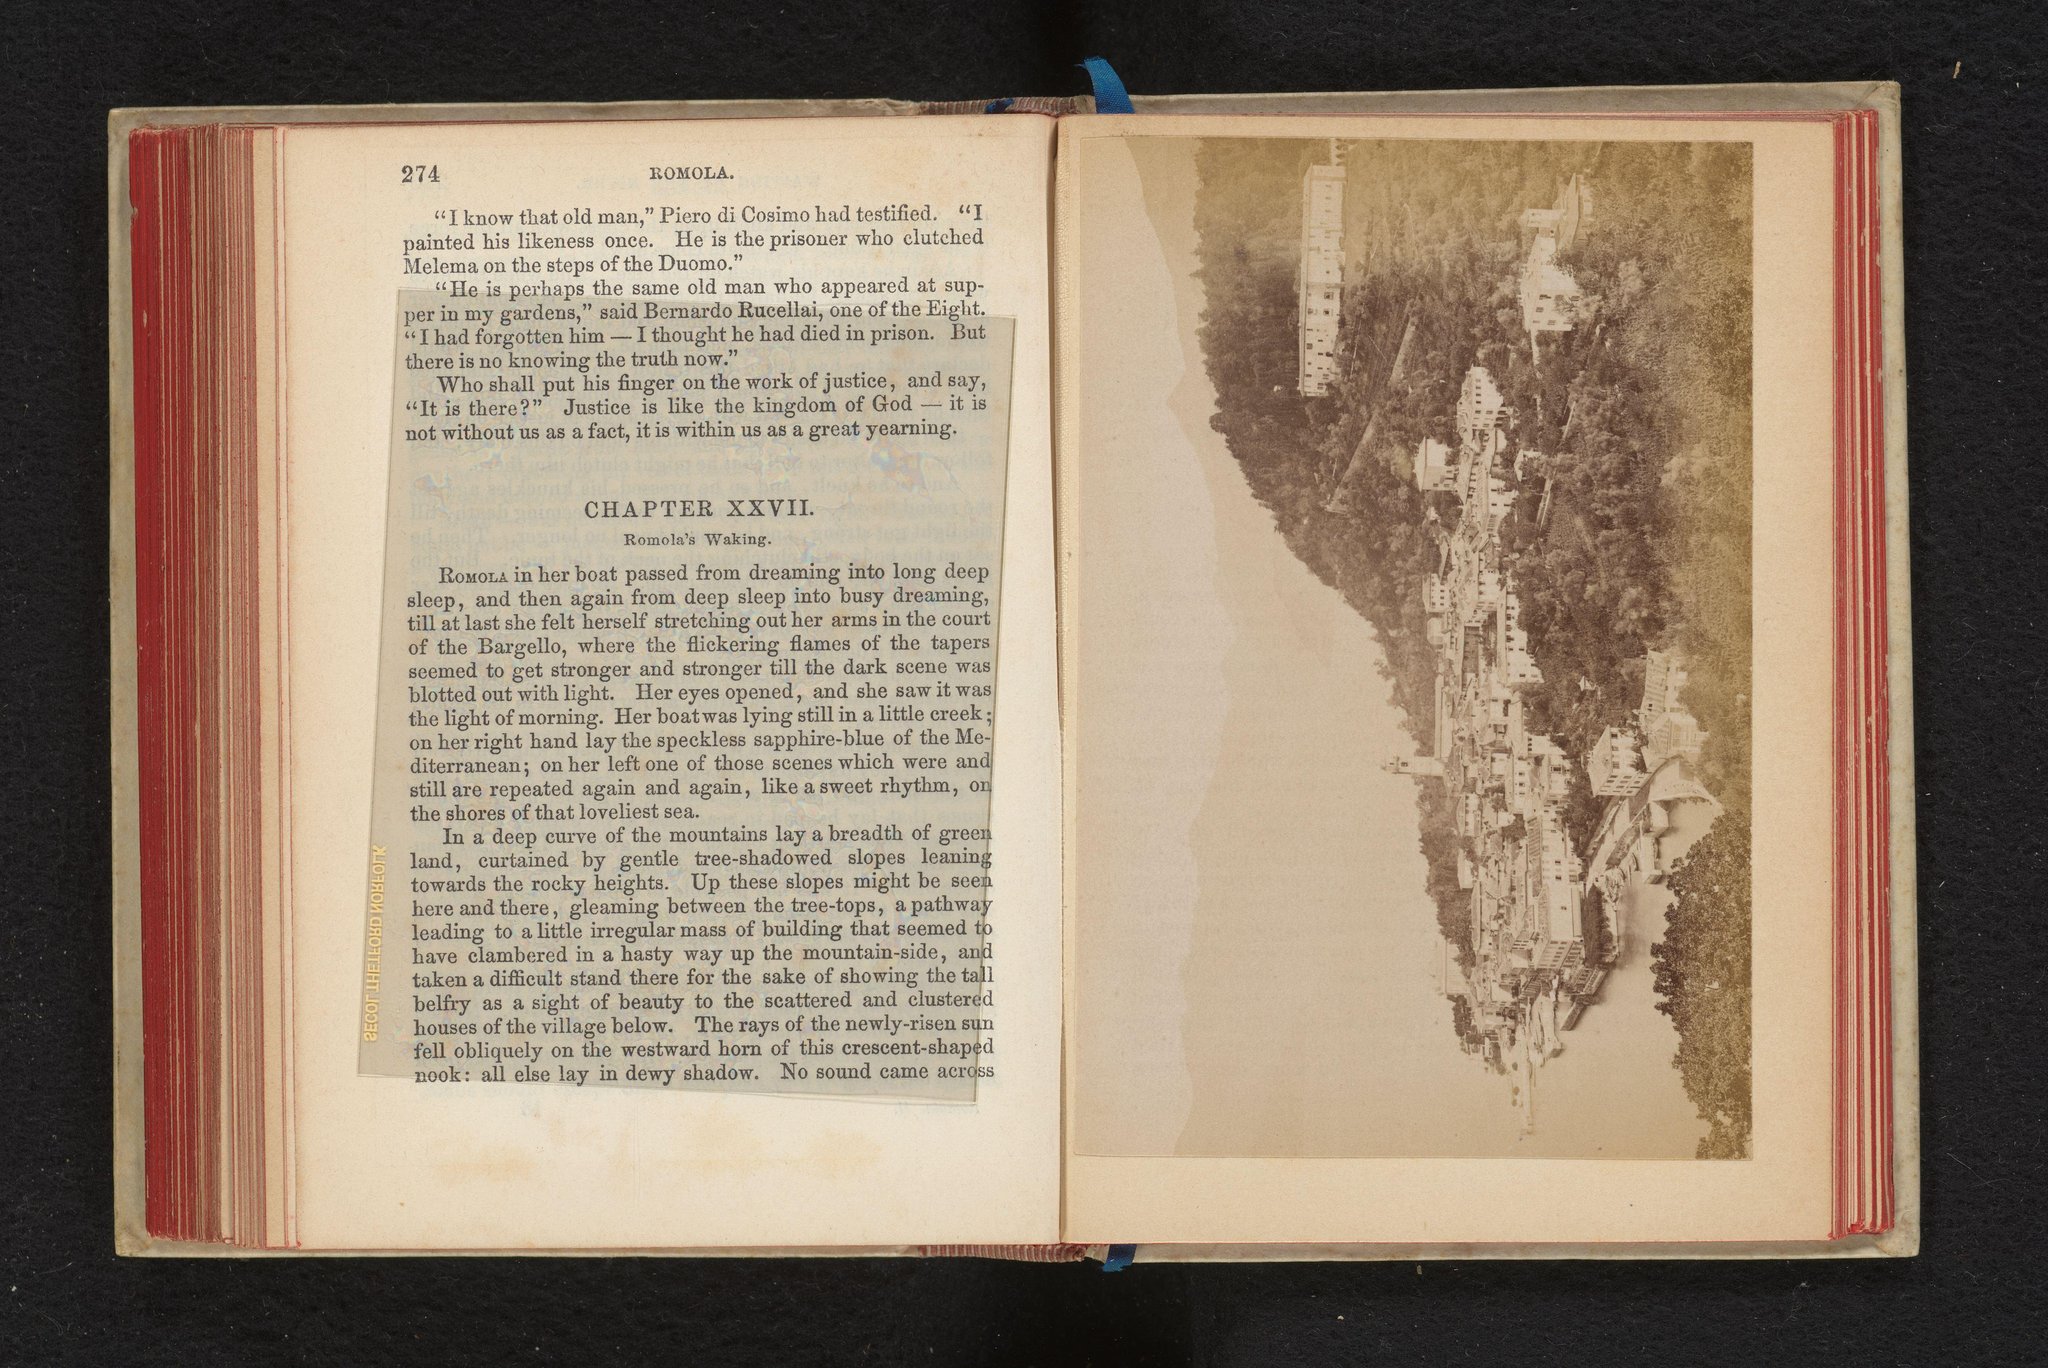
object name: page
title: Gezicht op Bellagio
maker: giacomo brogi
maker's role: fotograaf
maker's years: 1822-1881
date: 1858-1863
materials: paper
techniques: albumen print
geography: bellagio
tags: prospect of village, silhouette of village, lake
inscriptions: name: ‘Brogi’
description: Foto op ongenummerde pagina tegenover pagina 274.